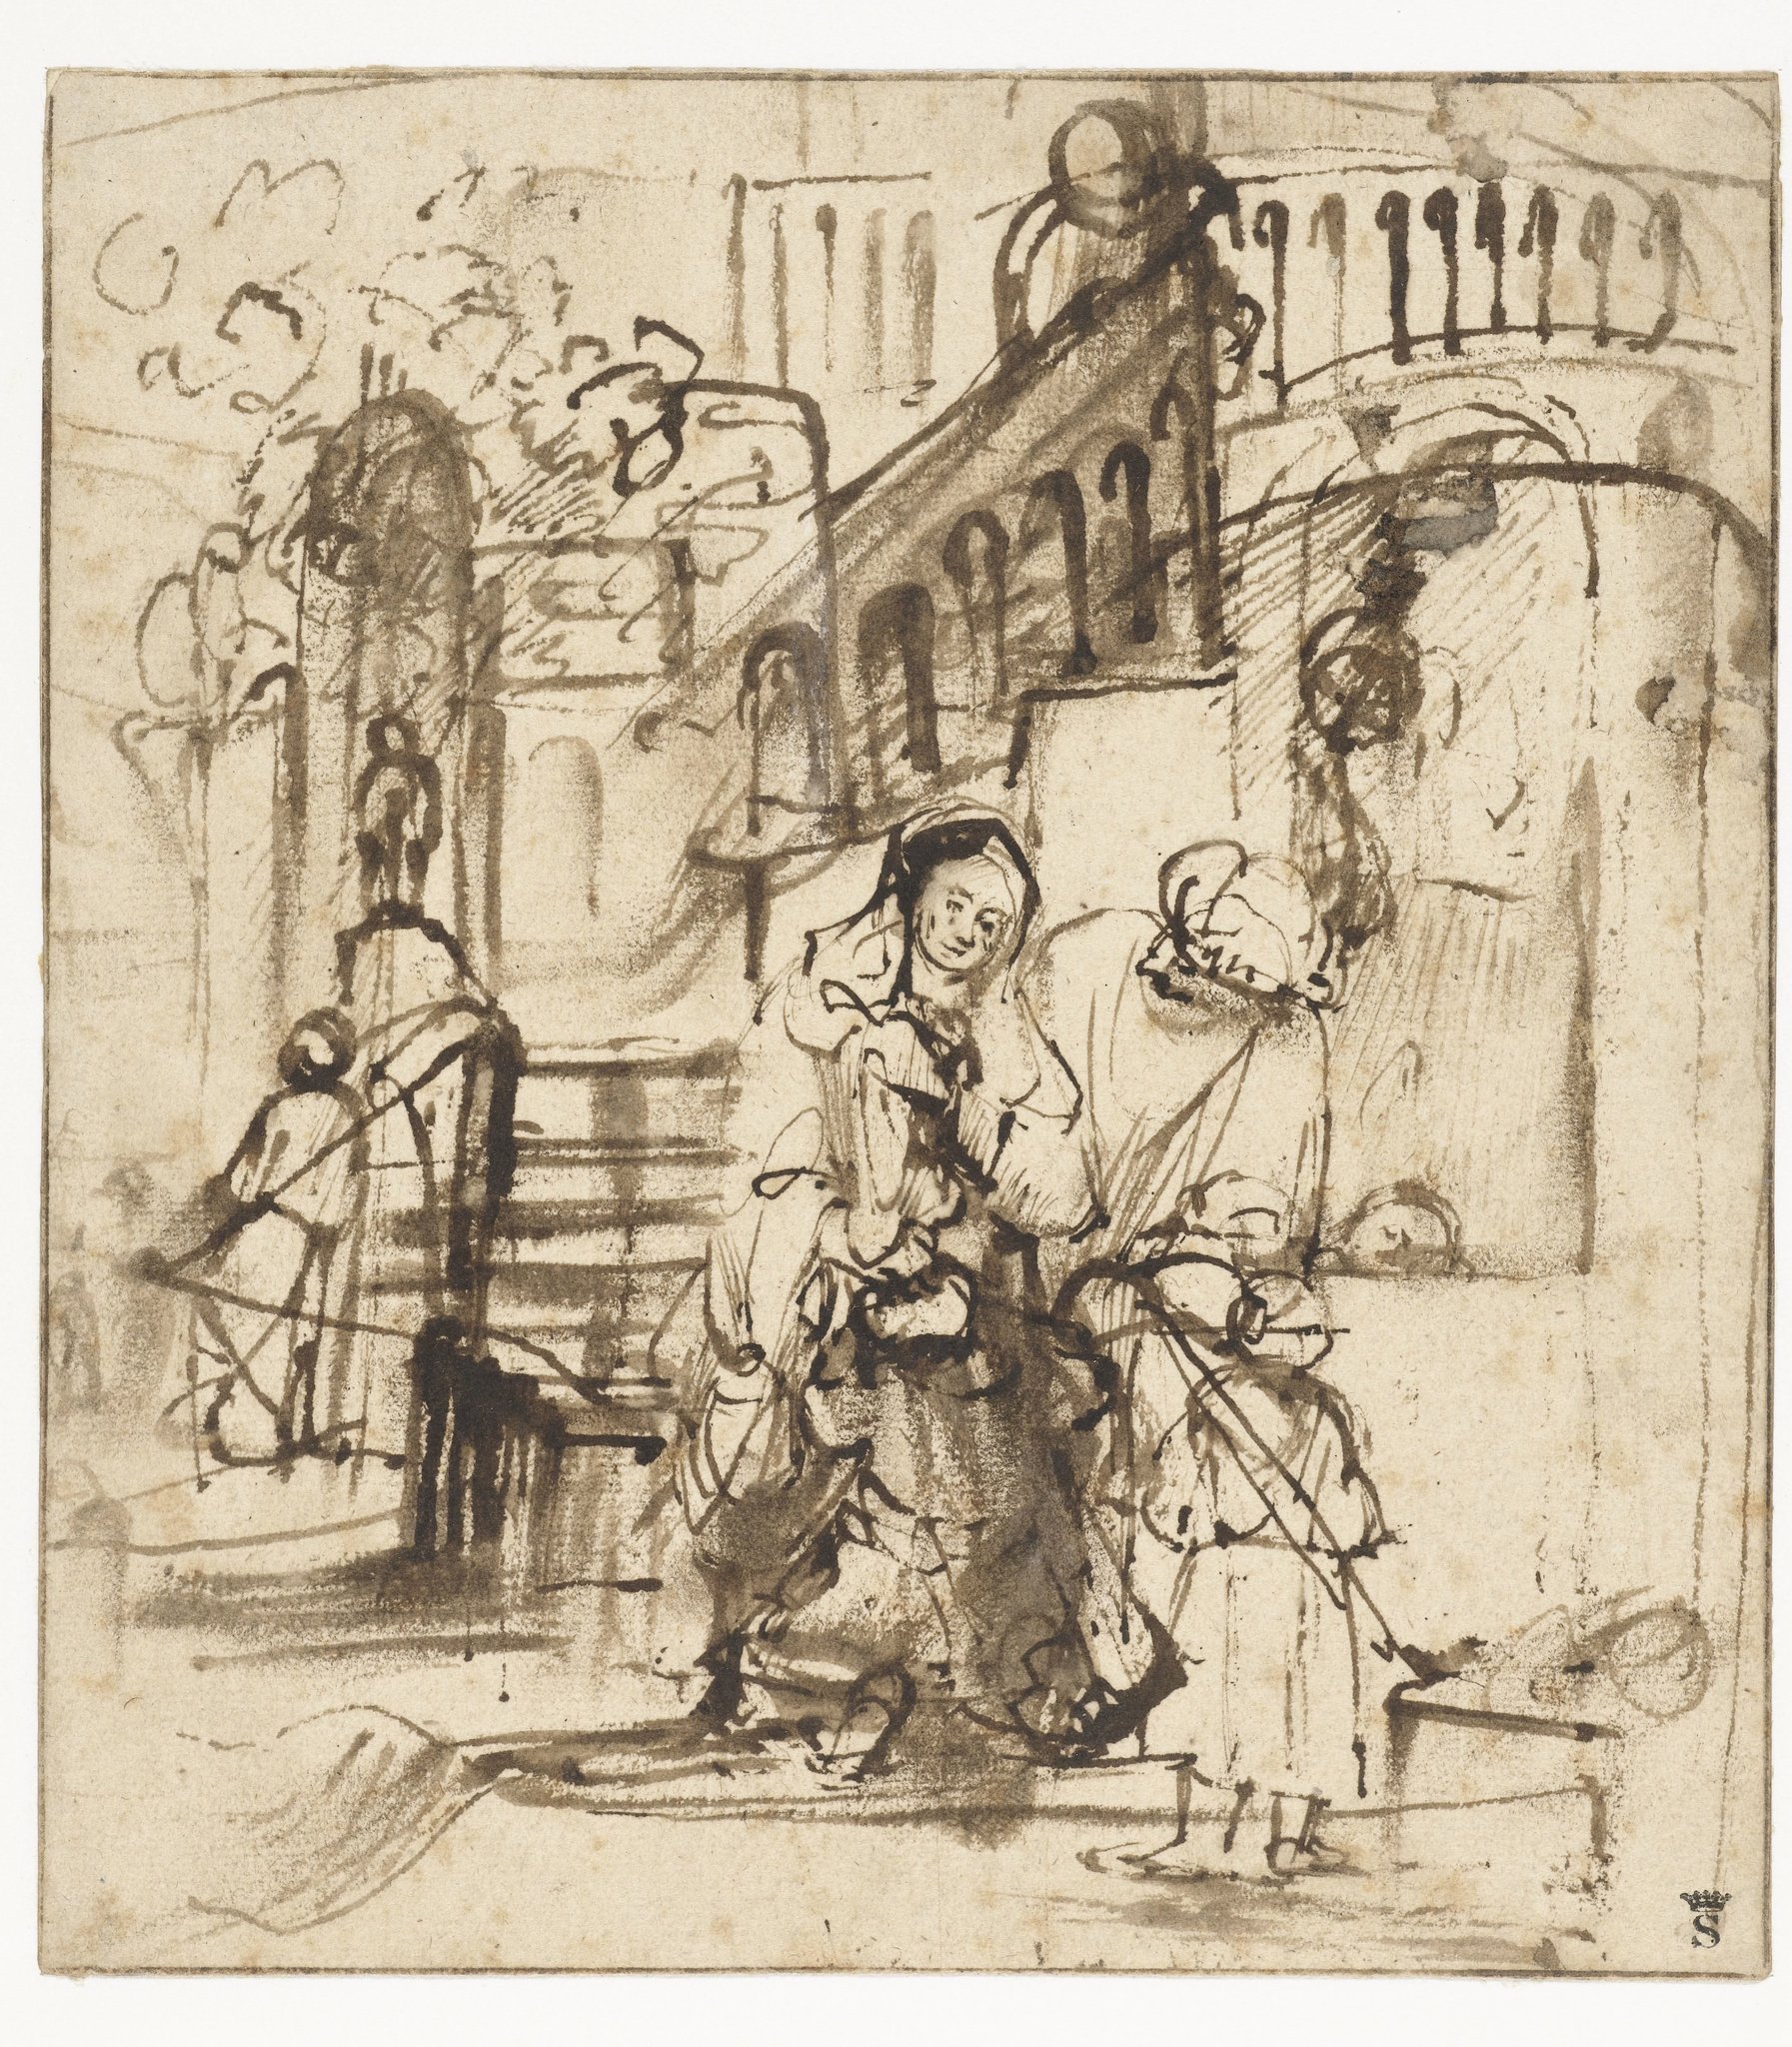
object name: drawing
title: The Dismissal of Hagar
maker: aert de gelder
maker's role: draughtsman, painter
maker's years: 1645-1727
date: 1680-1727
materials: ink, paper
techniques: brush, pen